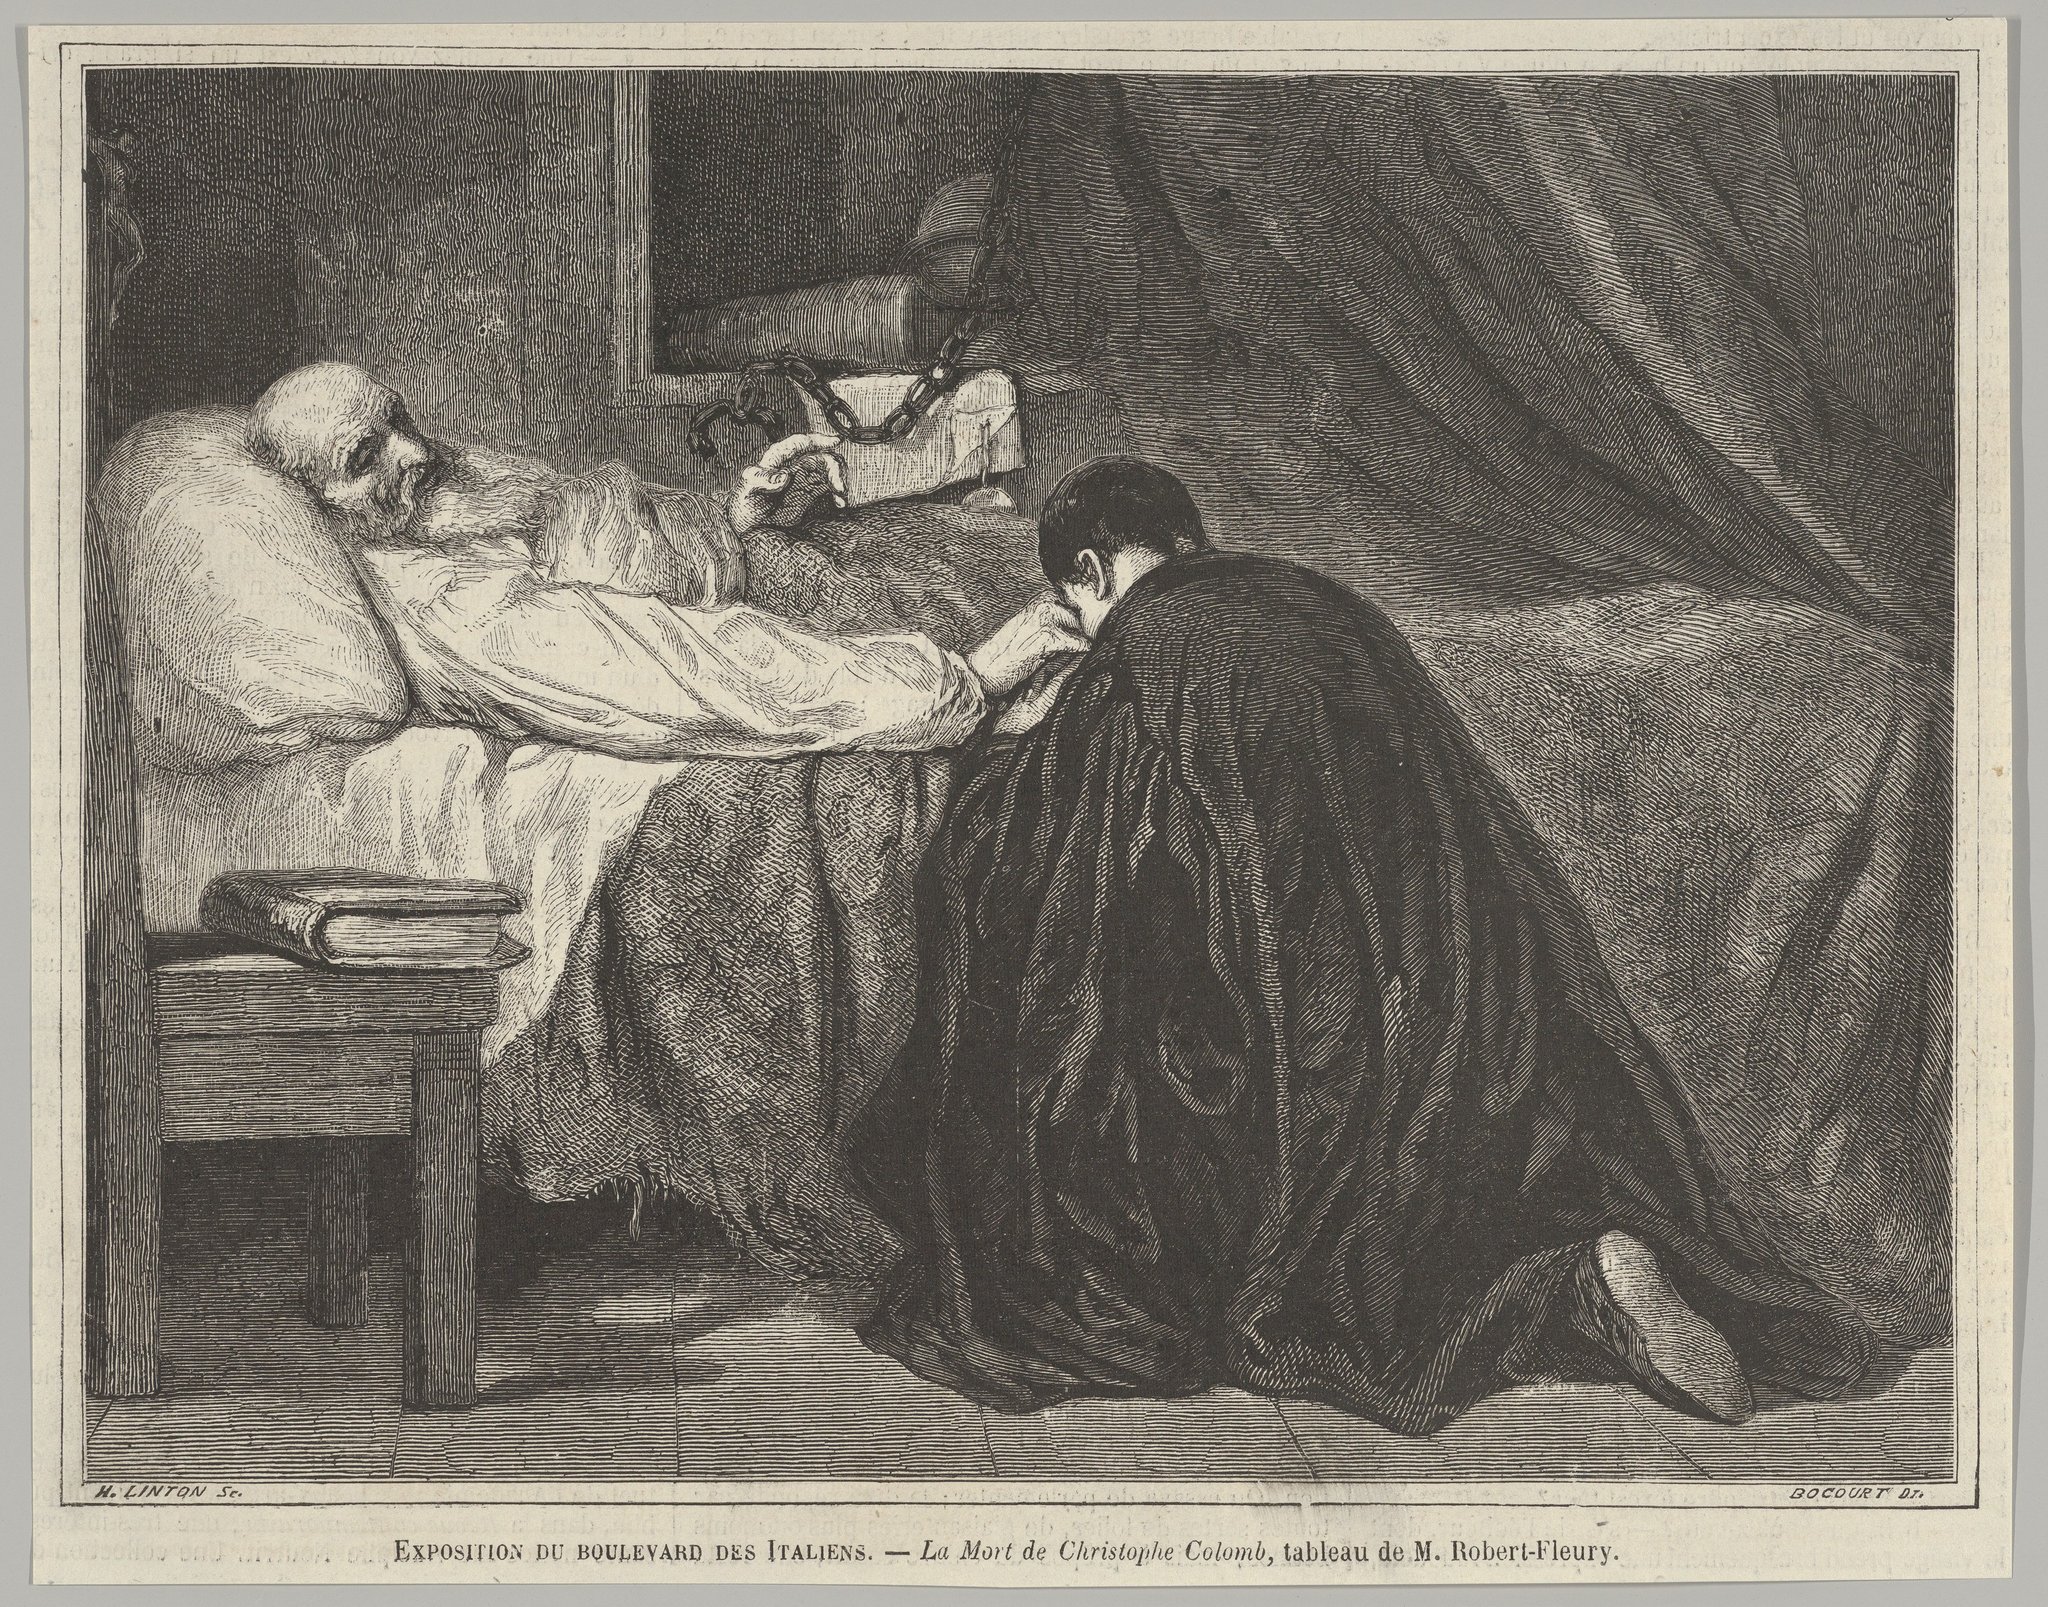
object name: print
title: The Death of Christopher Columbus, from "Le Monde Illustré"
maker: henry linton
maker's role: engraver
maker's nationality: british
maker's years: 1815-1899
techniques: engraving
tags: christopher columbus,men,death